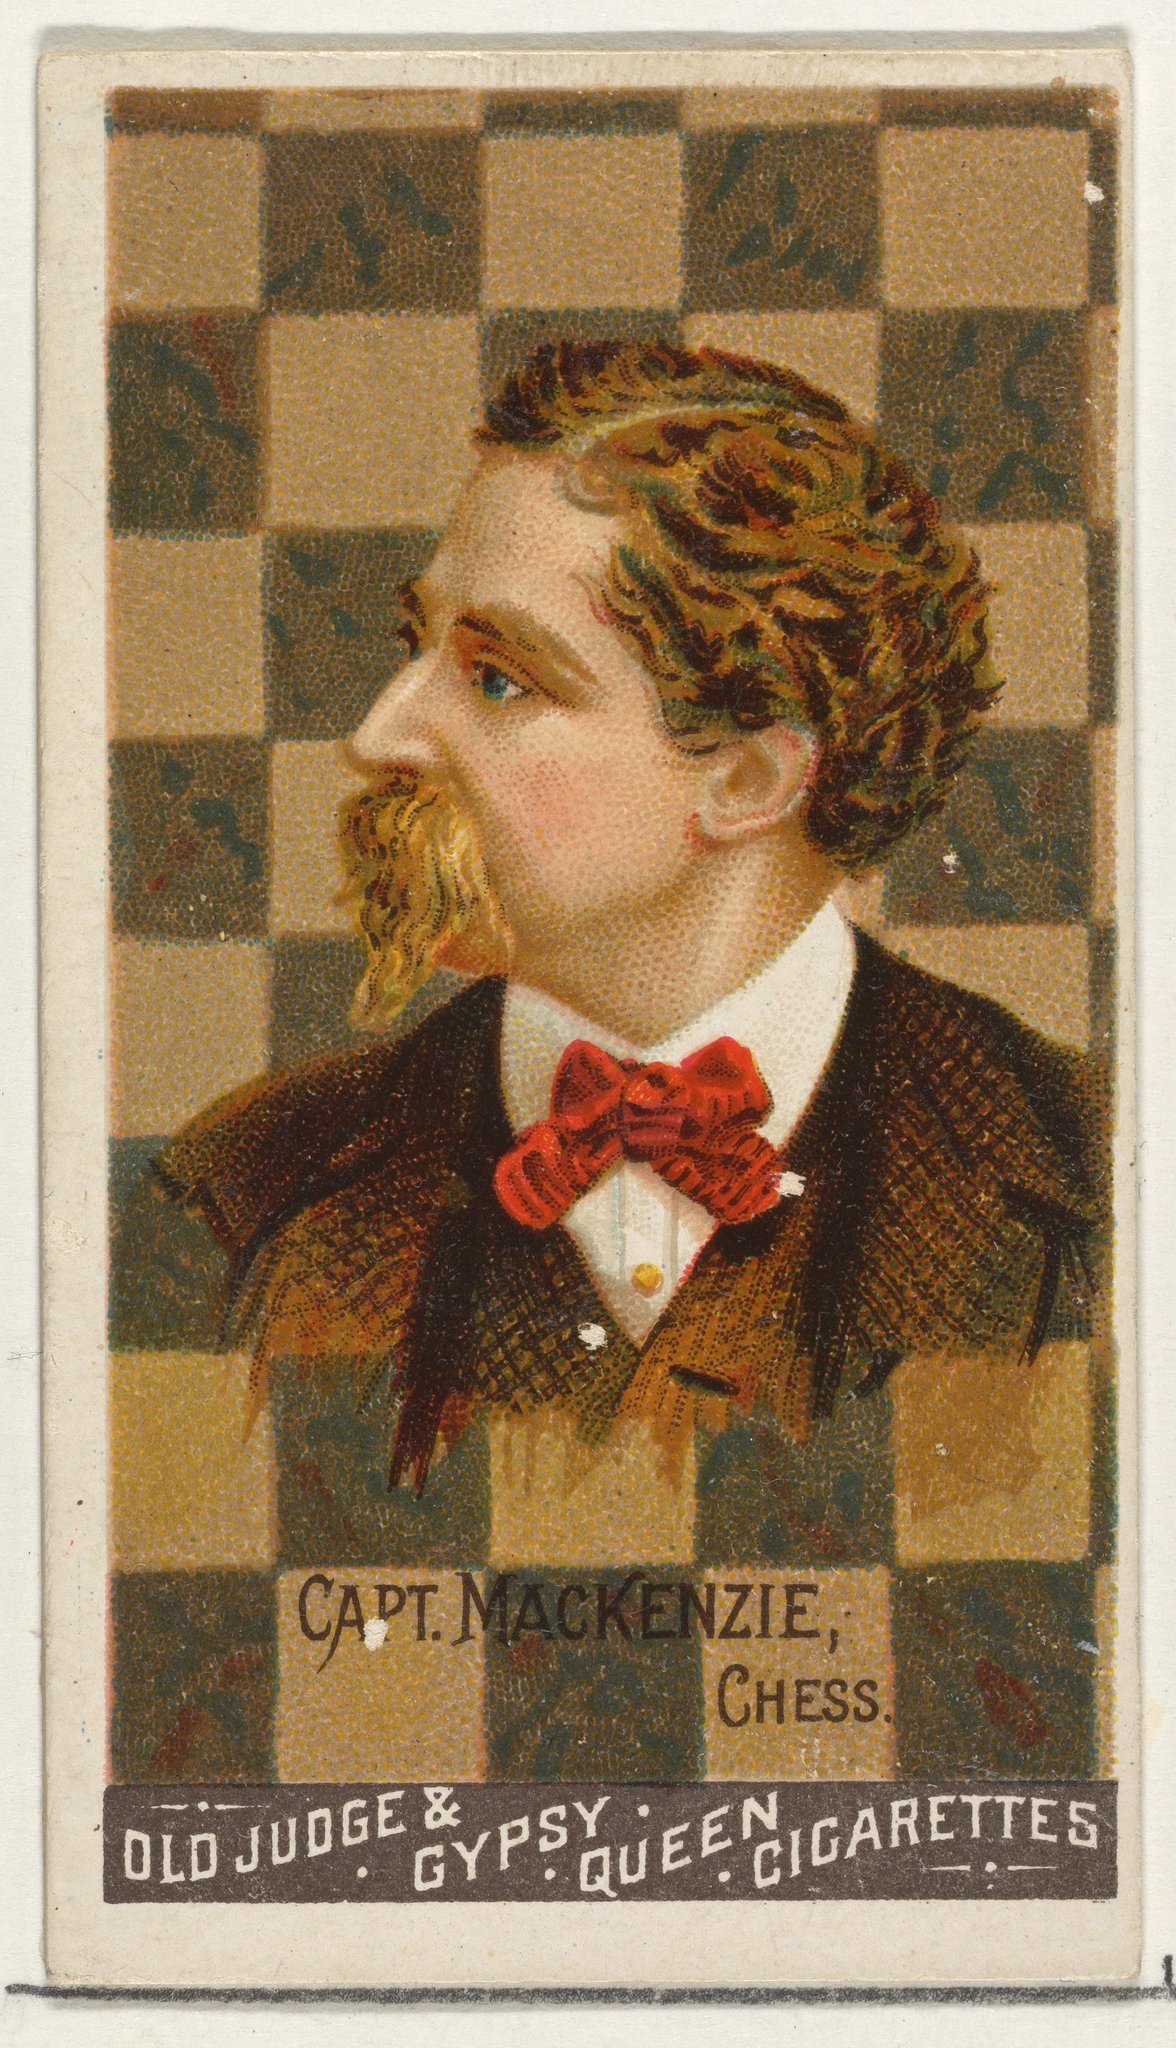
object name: print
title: Captain Mackenzie, Chess, from the Goodwin Champion series for Old Judge and Gypsy Queen Cigarettes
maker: goodwin & company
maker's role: publisher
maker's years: 1850-1950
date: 1888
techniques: color lithograph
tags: men,profiles